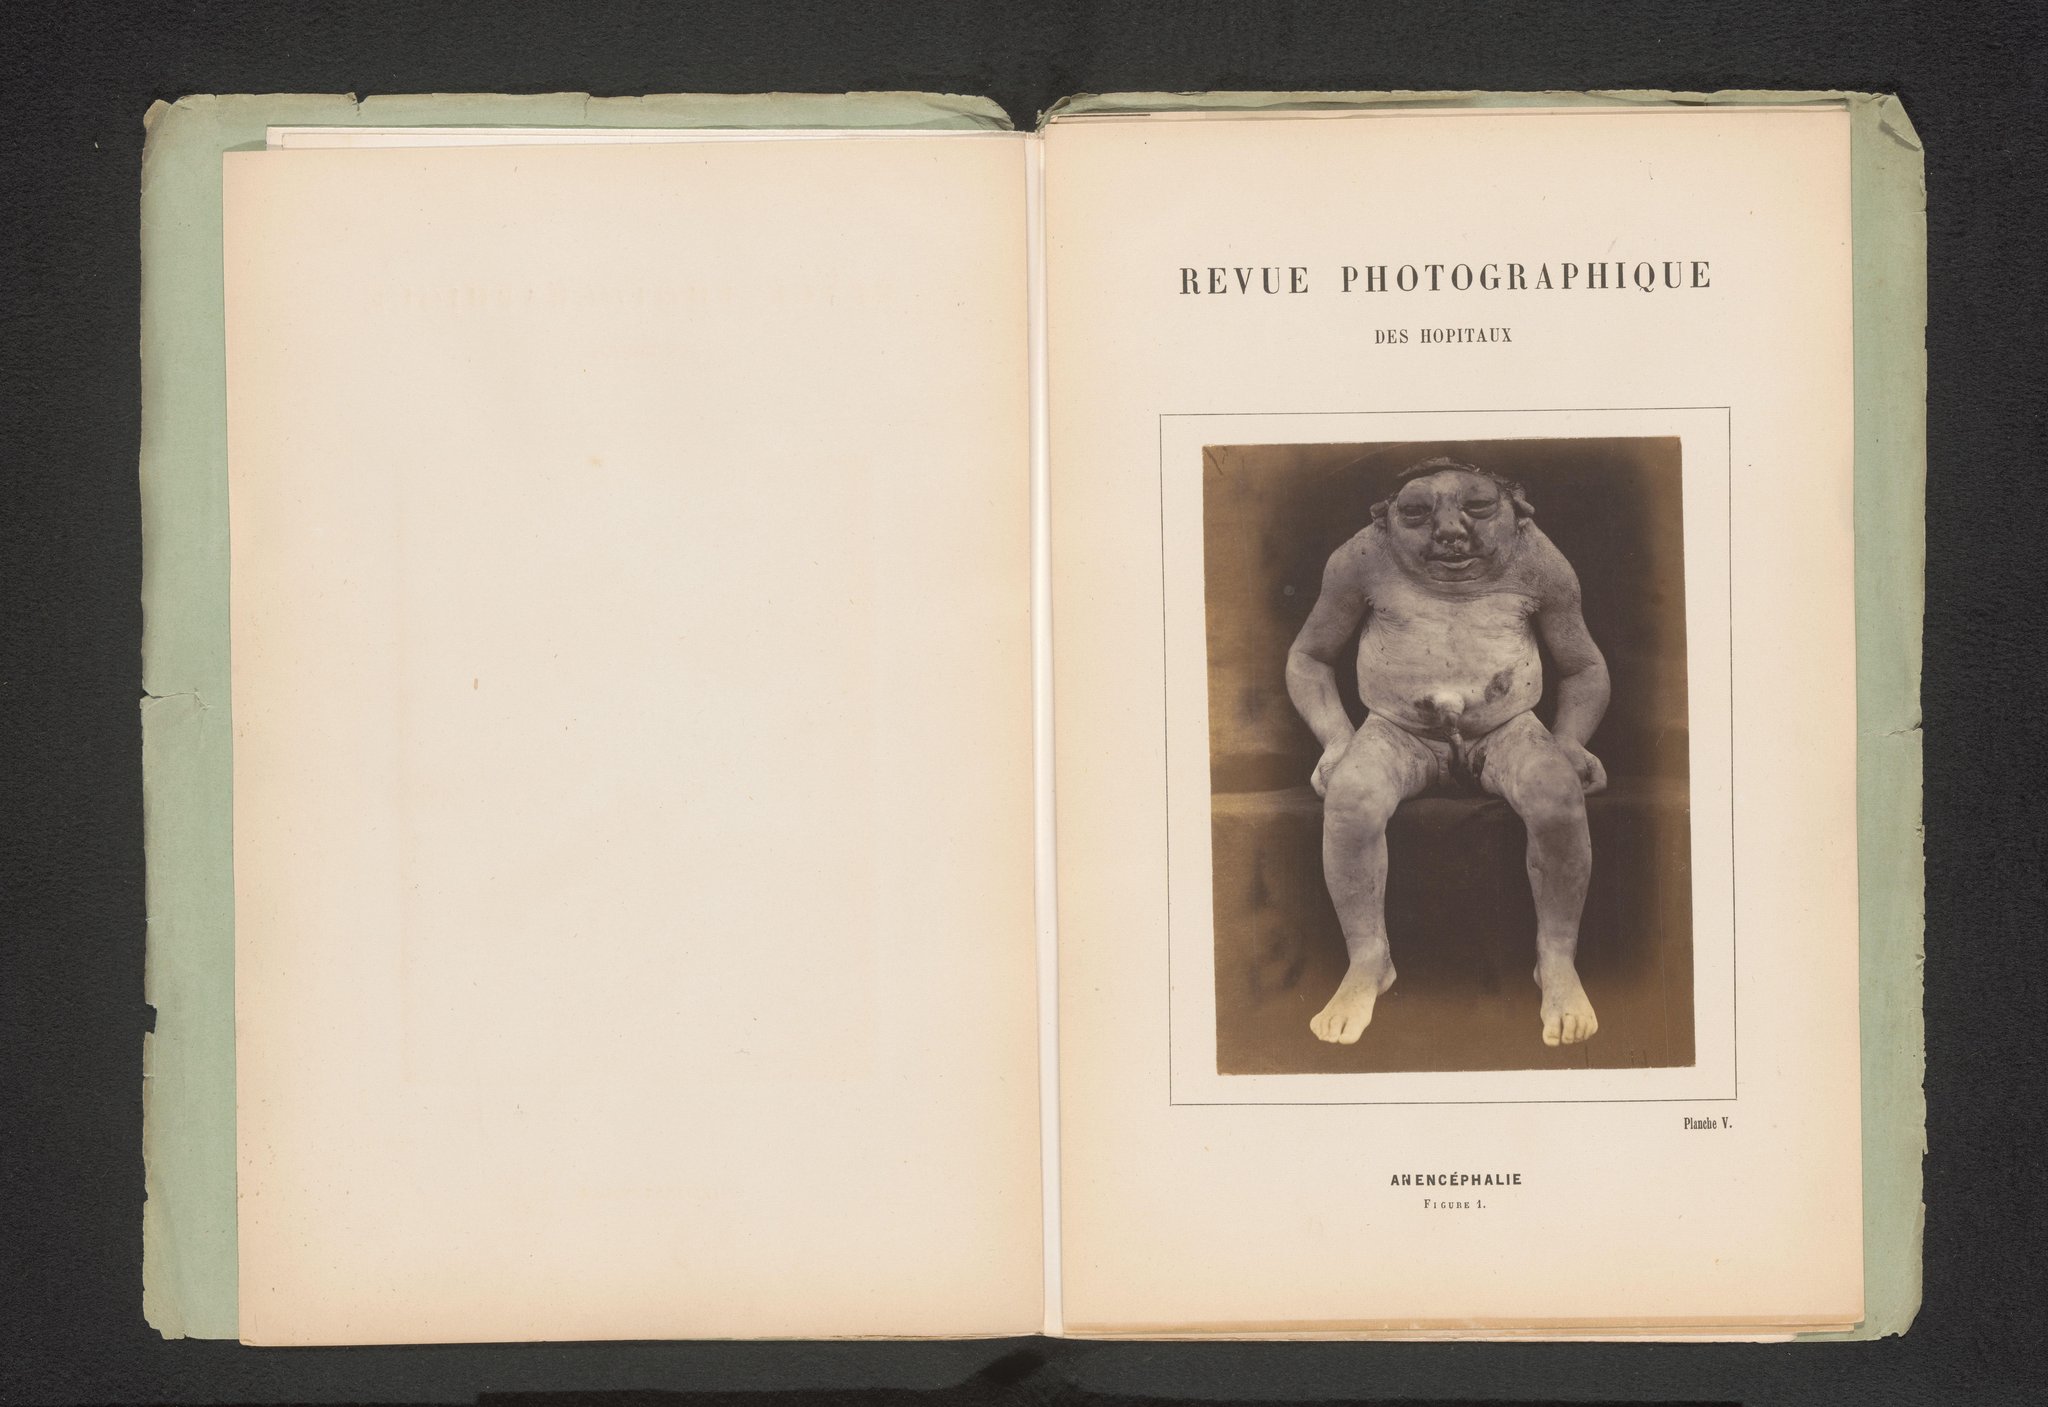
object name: page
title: Anencéphalie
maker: Anonymous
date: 1865-1870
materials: paper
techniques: albumen print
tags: diseases of the head or parts of the head, medical research, branches of medicine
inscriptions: inscription: ‘Revue photographique/ des hopitaux/ Planche V.’